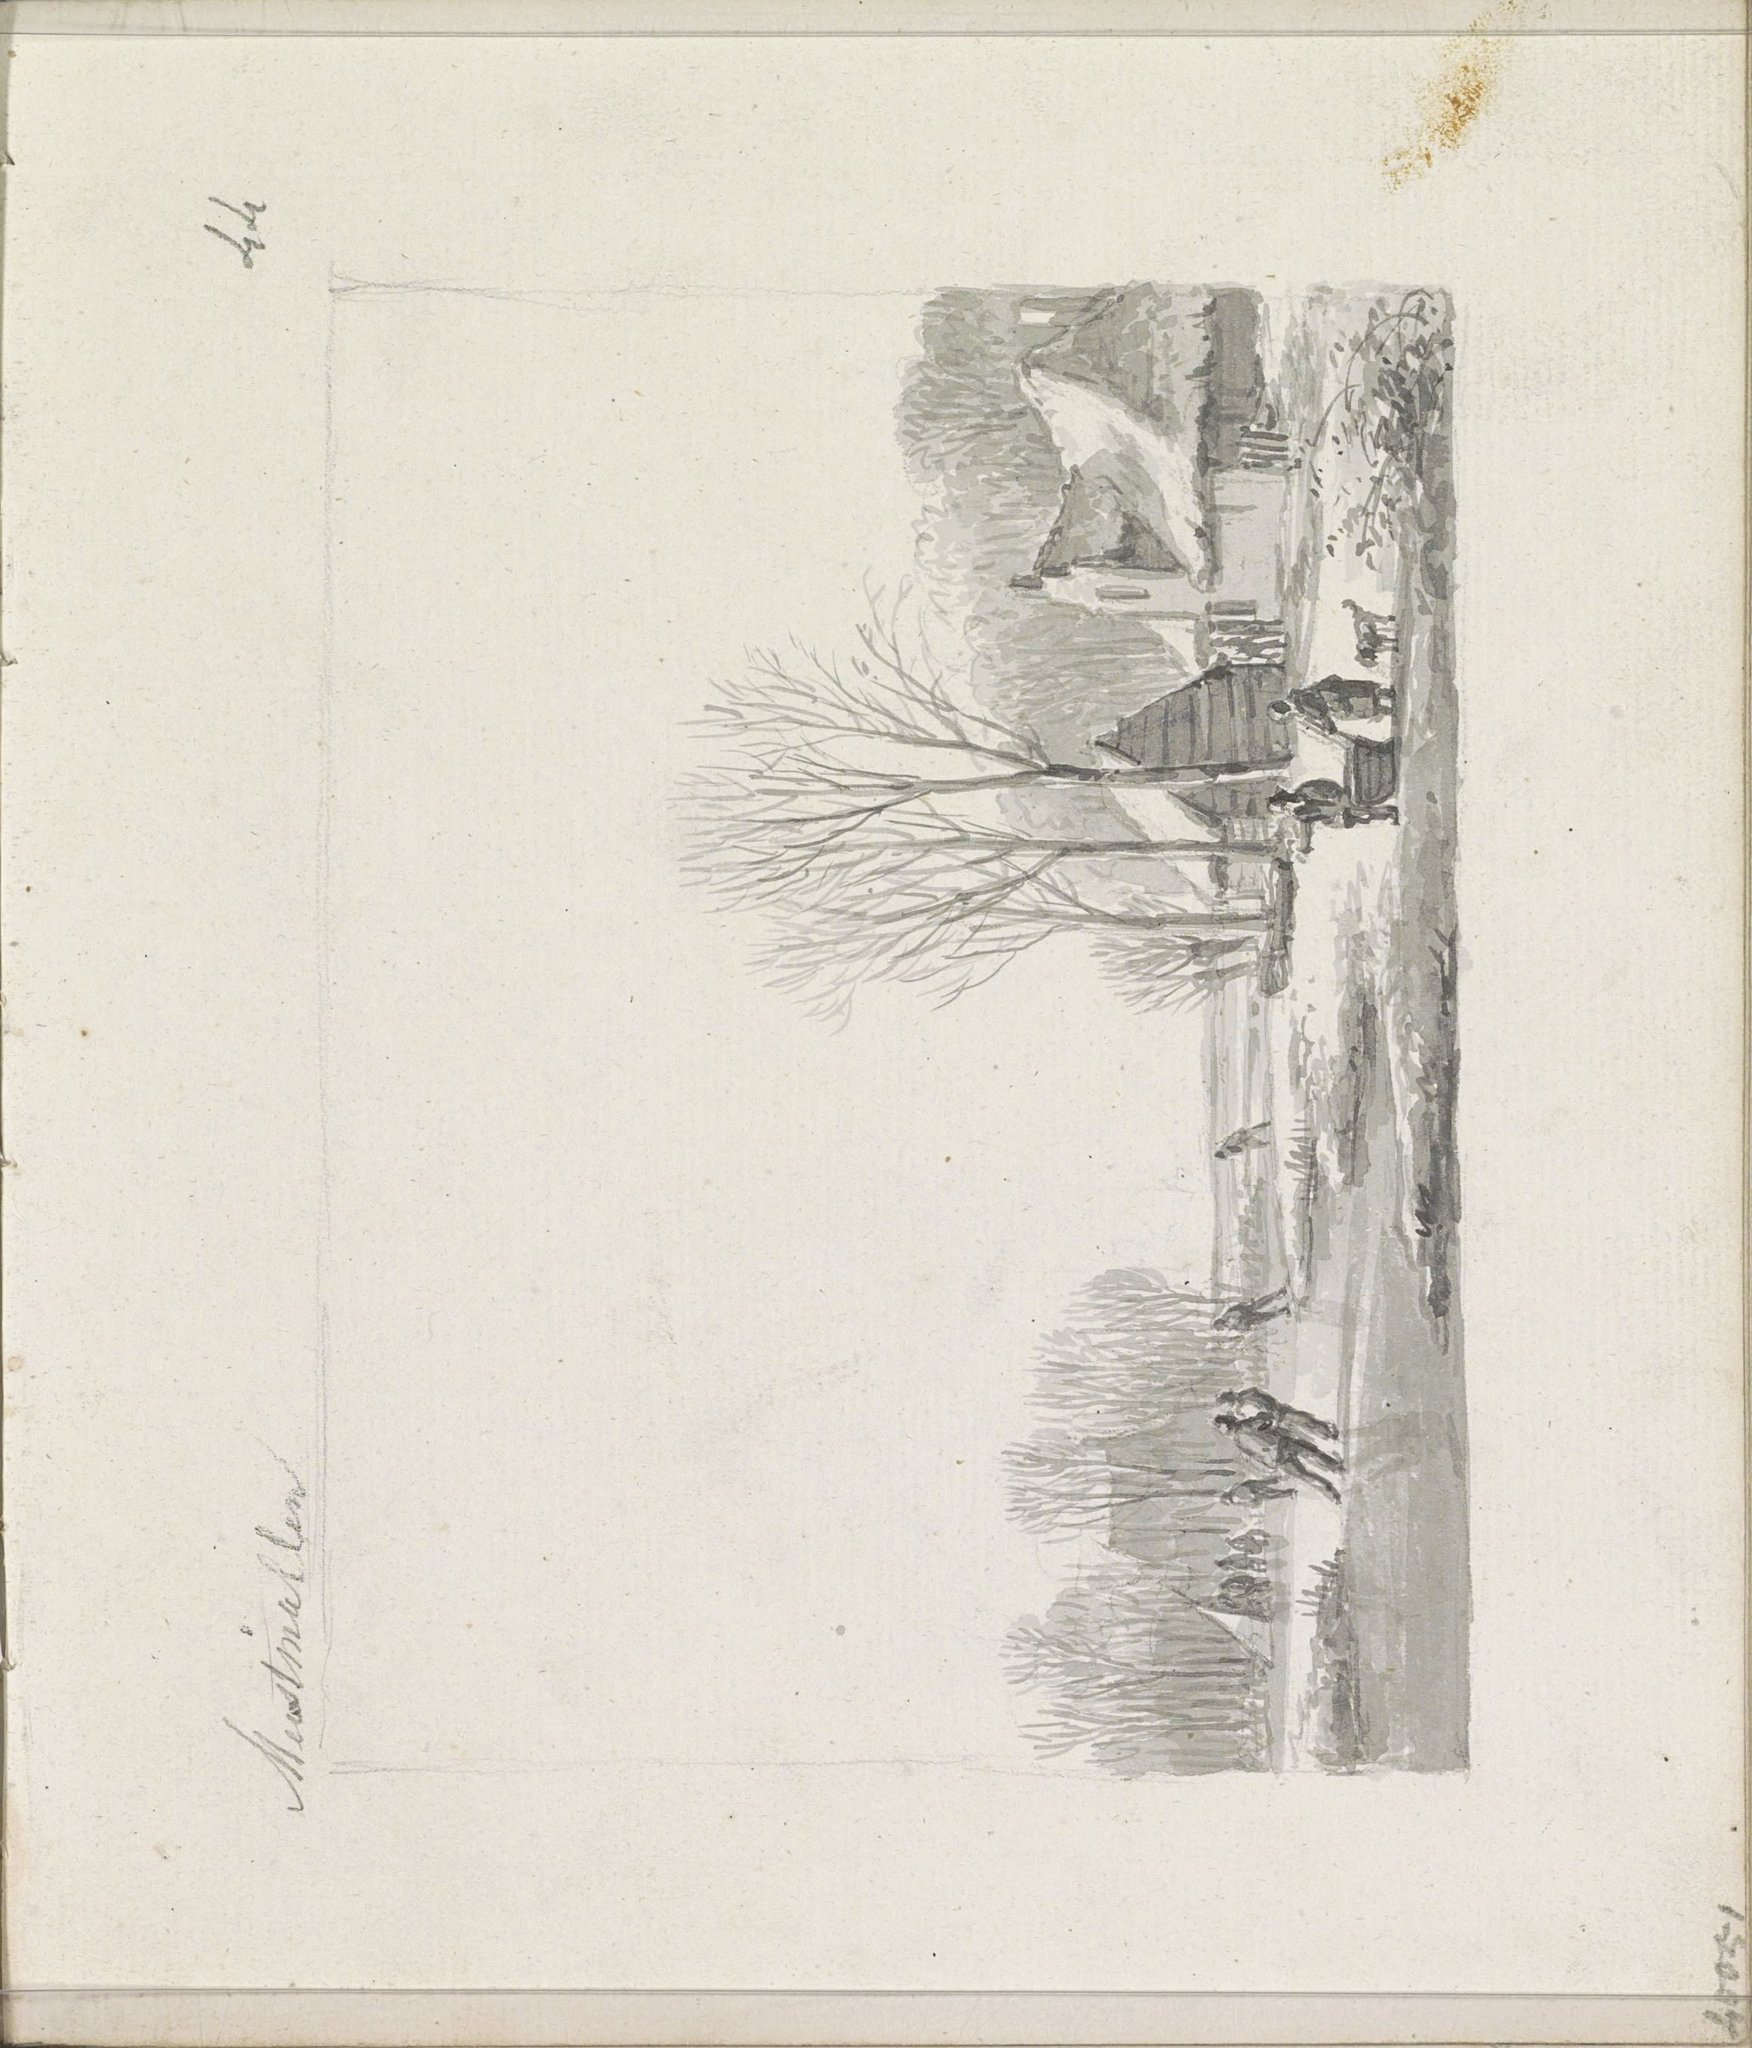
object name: sketchbook leaf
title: Schaatsers op een bevroren vaart langs boerenwoningen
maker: andreas schelfhout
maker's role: draughtsman, painter, print maker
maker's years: 1787-1870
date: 1825-1829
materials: paper, pencil, watercolor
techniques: brush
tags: frost, freezing weather, skates (winter sports), farm (building)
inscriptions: number: ‘44/ 40051’, annotation: ‘[...]tmallen’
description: Blad 58 recto uit een schetsboek met 95 bladen.